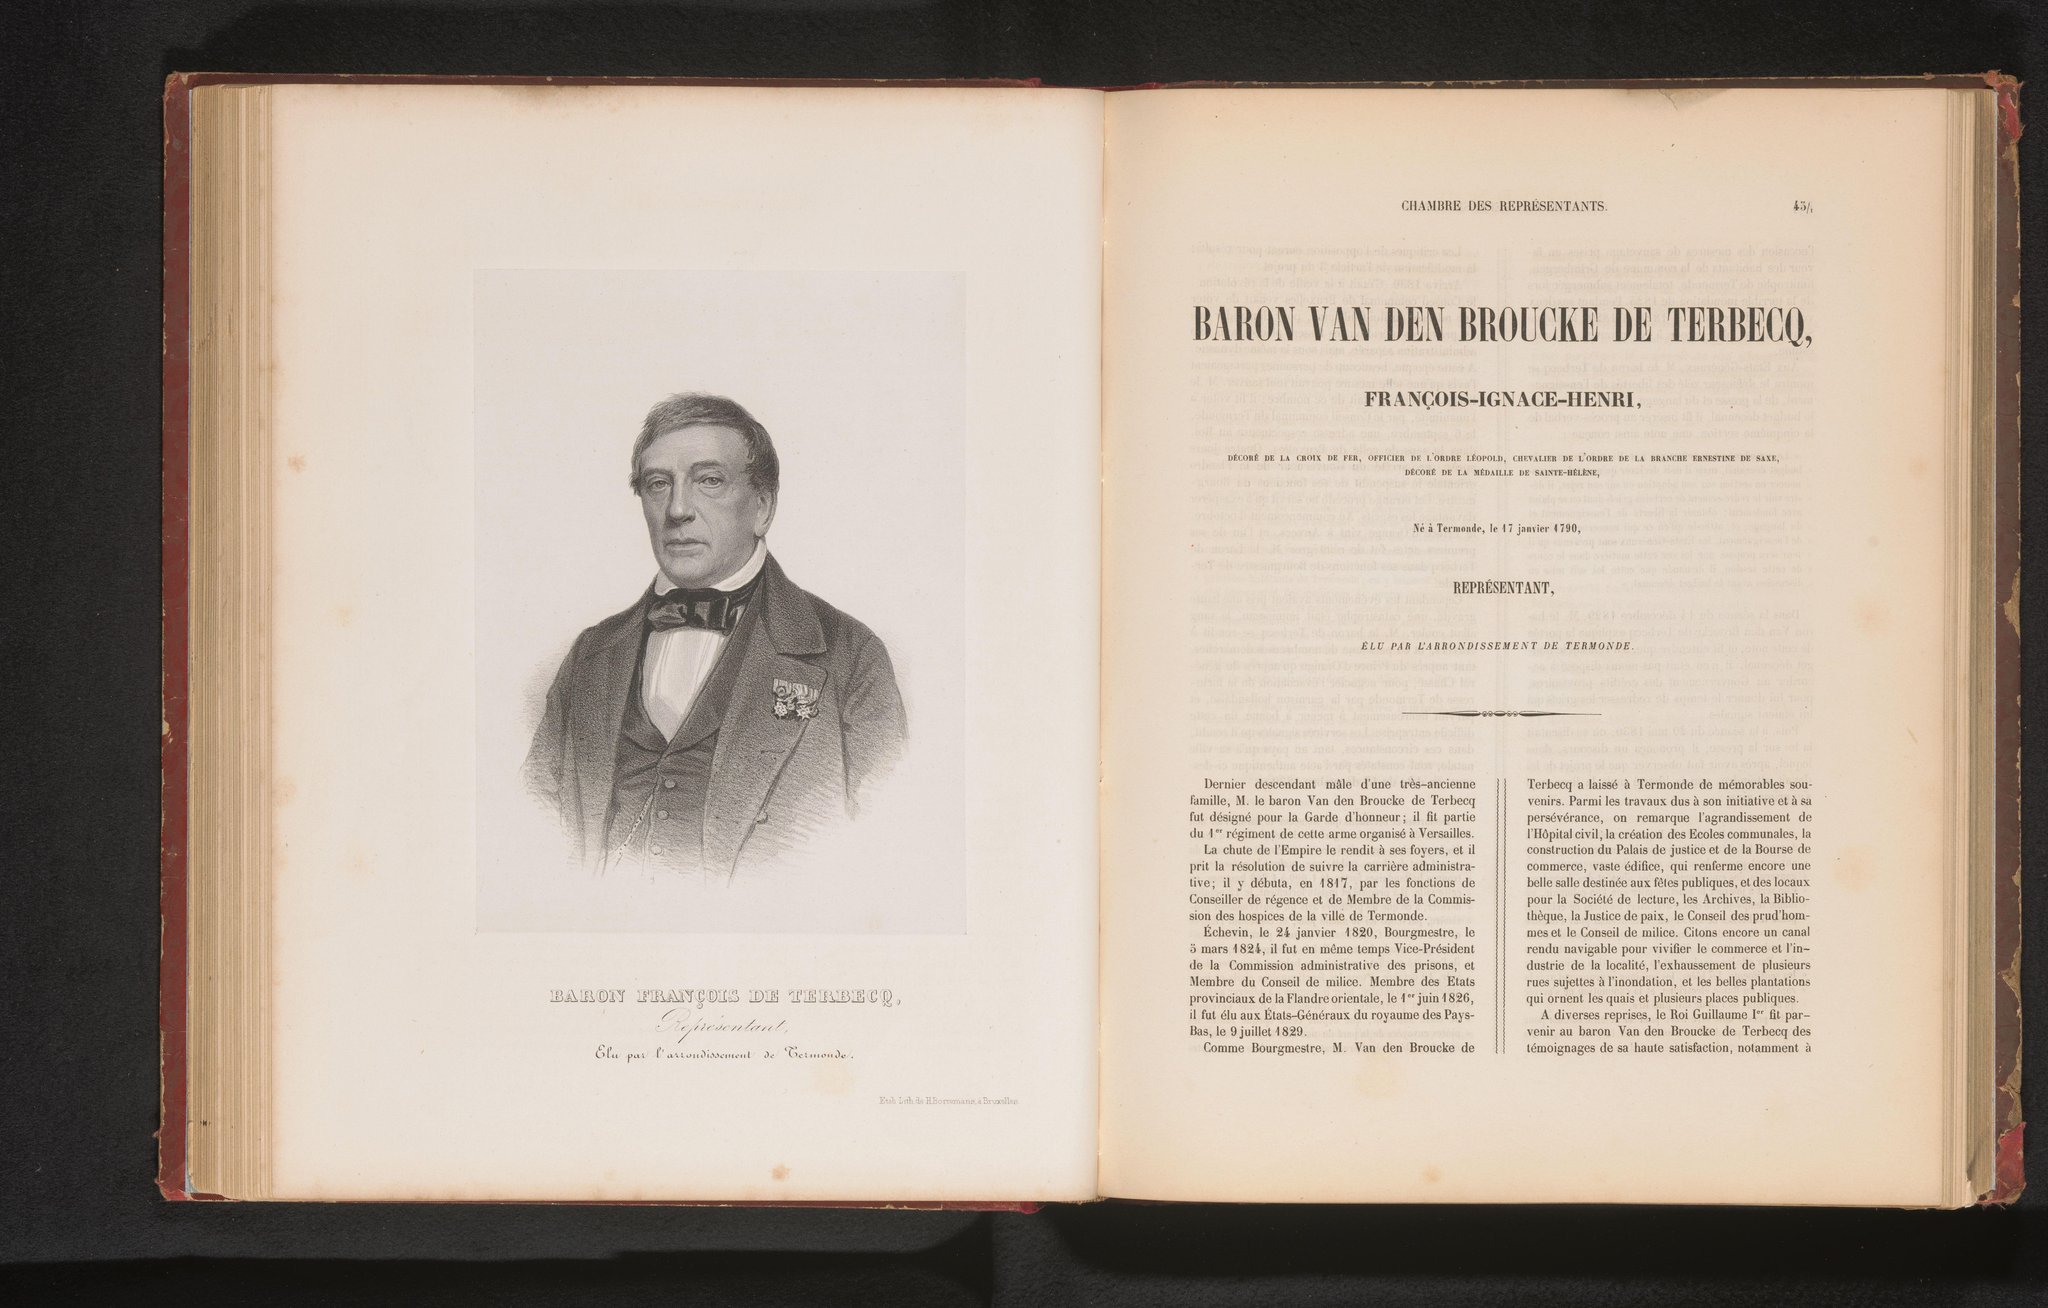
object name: print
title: Baron François de Terbecq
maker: henri borremans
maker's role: print maker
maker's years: 1800-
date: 1853-1858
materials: paper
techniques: lithograph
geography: brussels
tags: politician, historical persons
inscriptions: inscription: ‘Représentant,/ Elu par l'arrondissement de Termonde.’